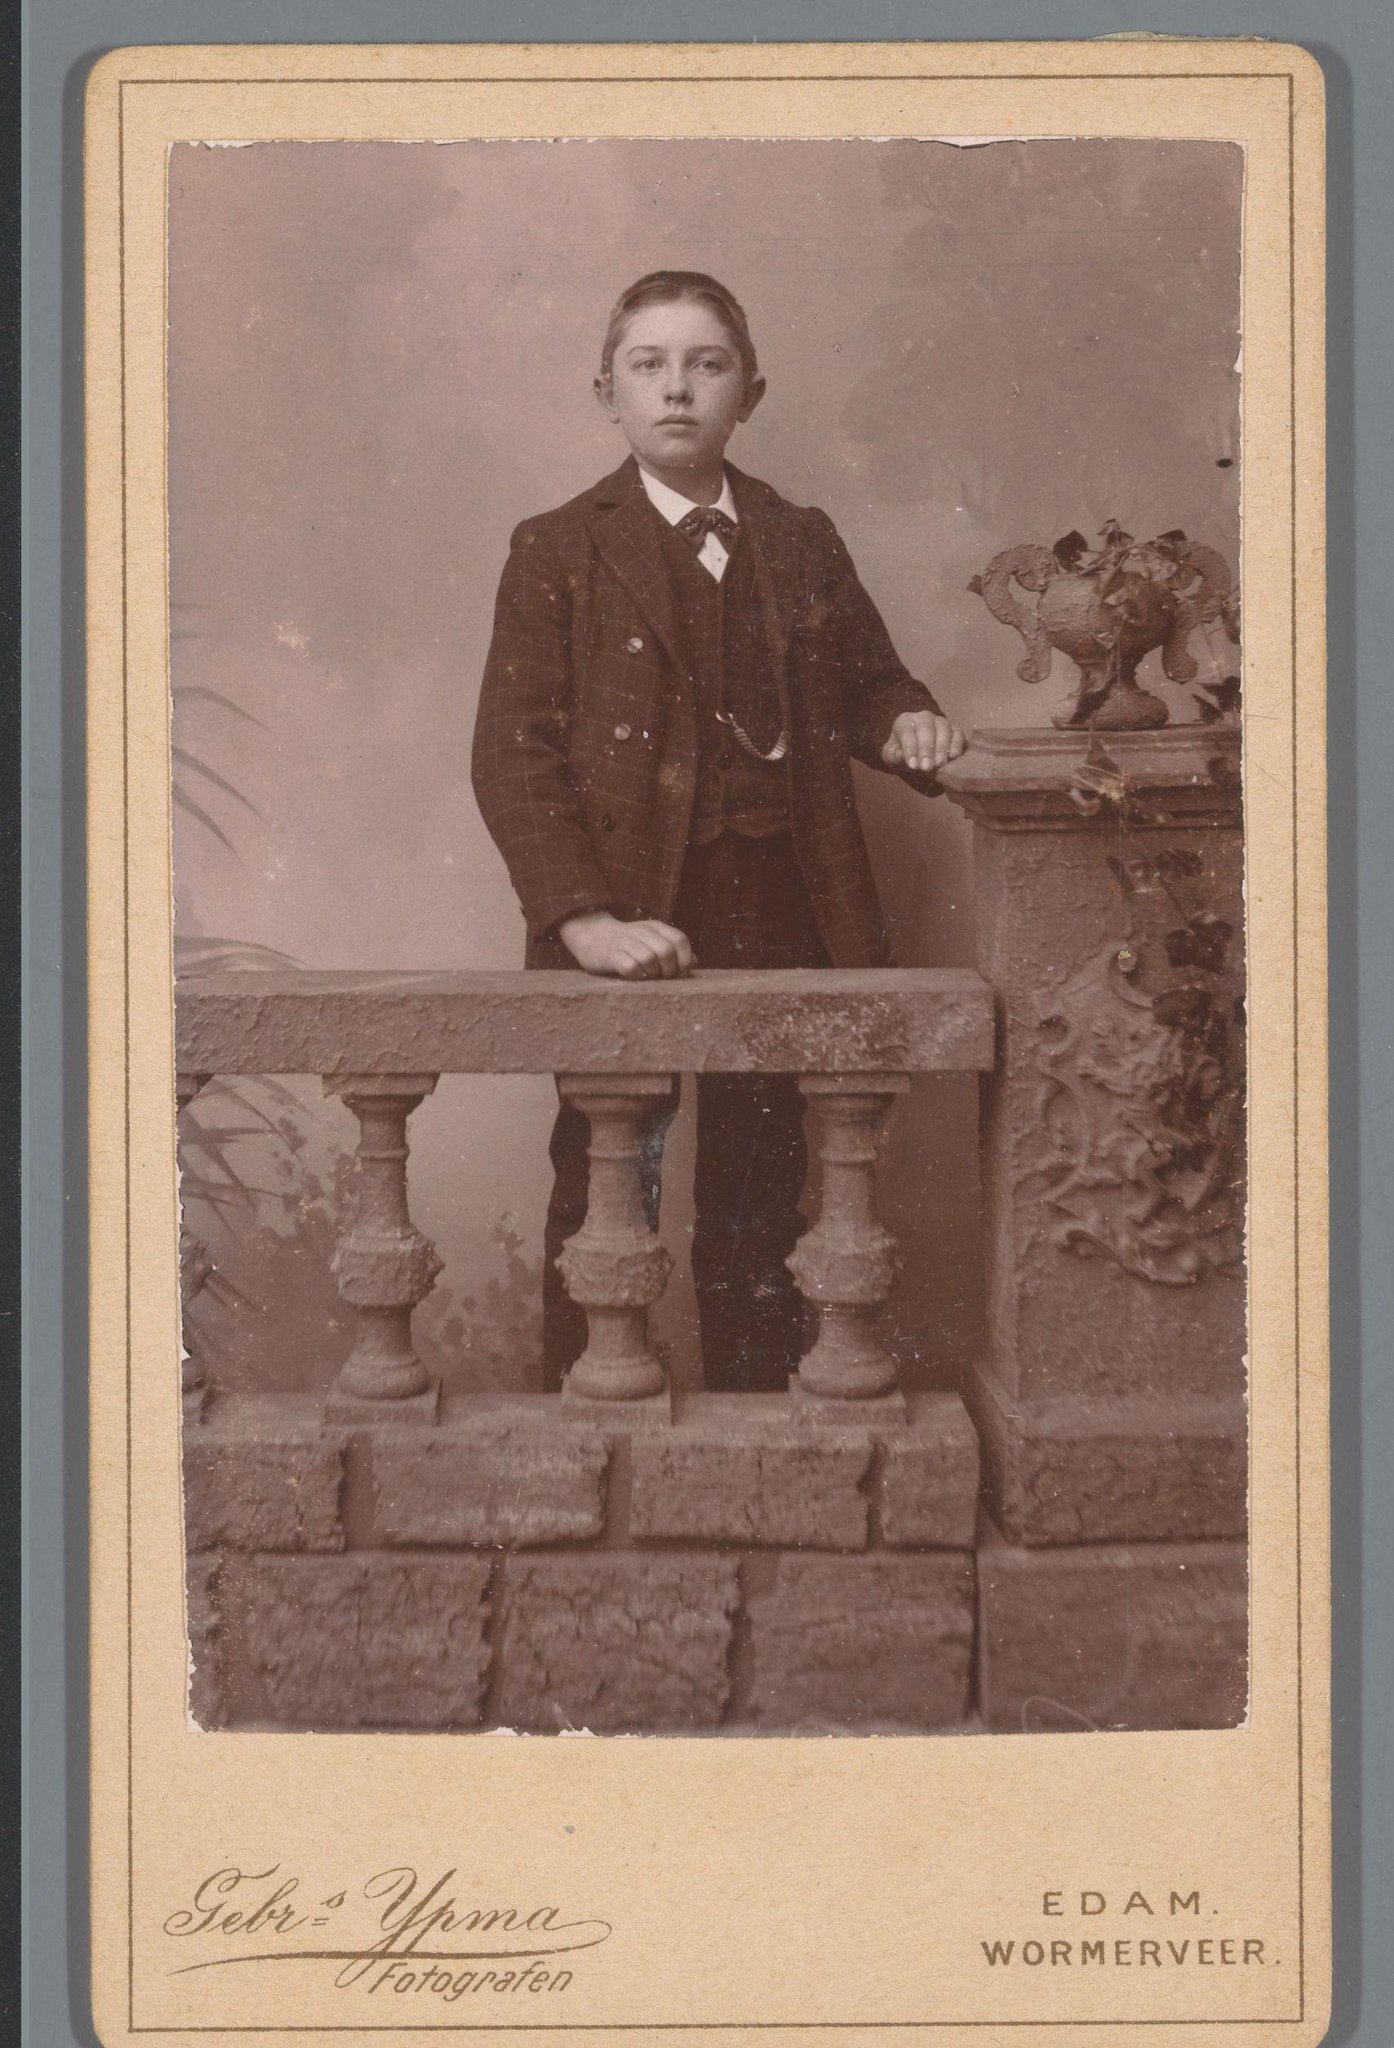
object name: photograph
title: Portret van een onbekende jongen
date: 1880-1914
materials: paper, cardboard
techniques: collodion silver print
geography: edam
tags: boy (child between toddler and youth), anonymous historical person portrayed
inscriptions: inscription: ‘Het cliché blijft voor nabestelling bewaard.’, address: ‘Edam,/ Wormerveer,/ Wandelweg.’